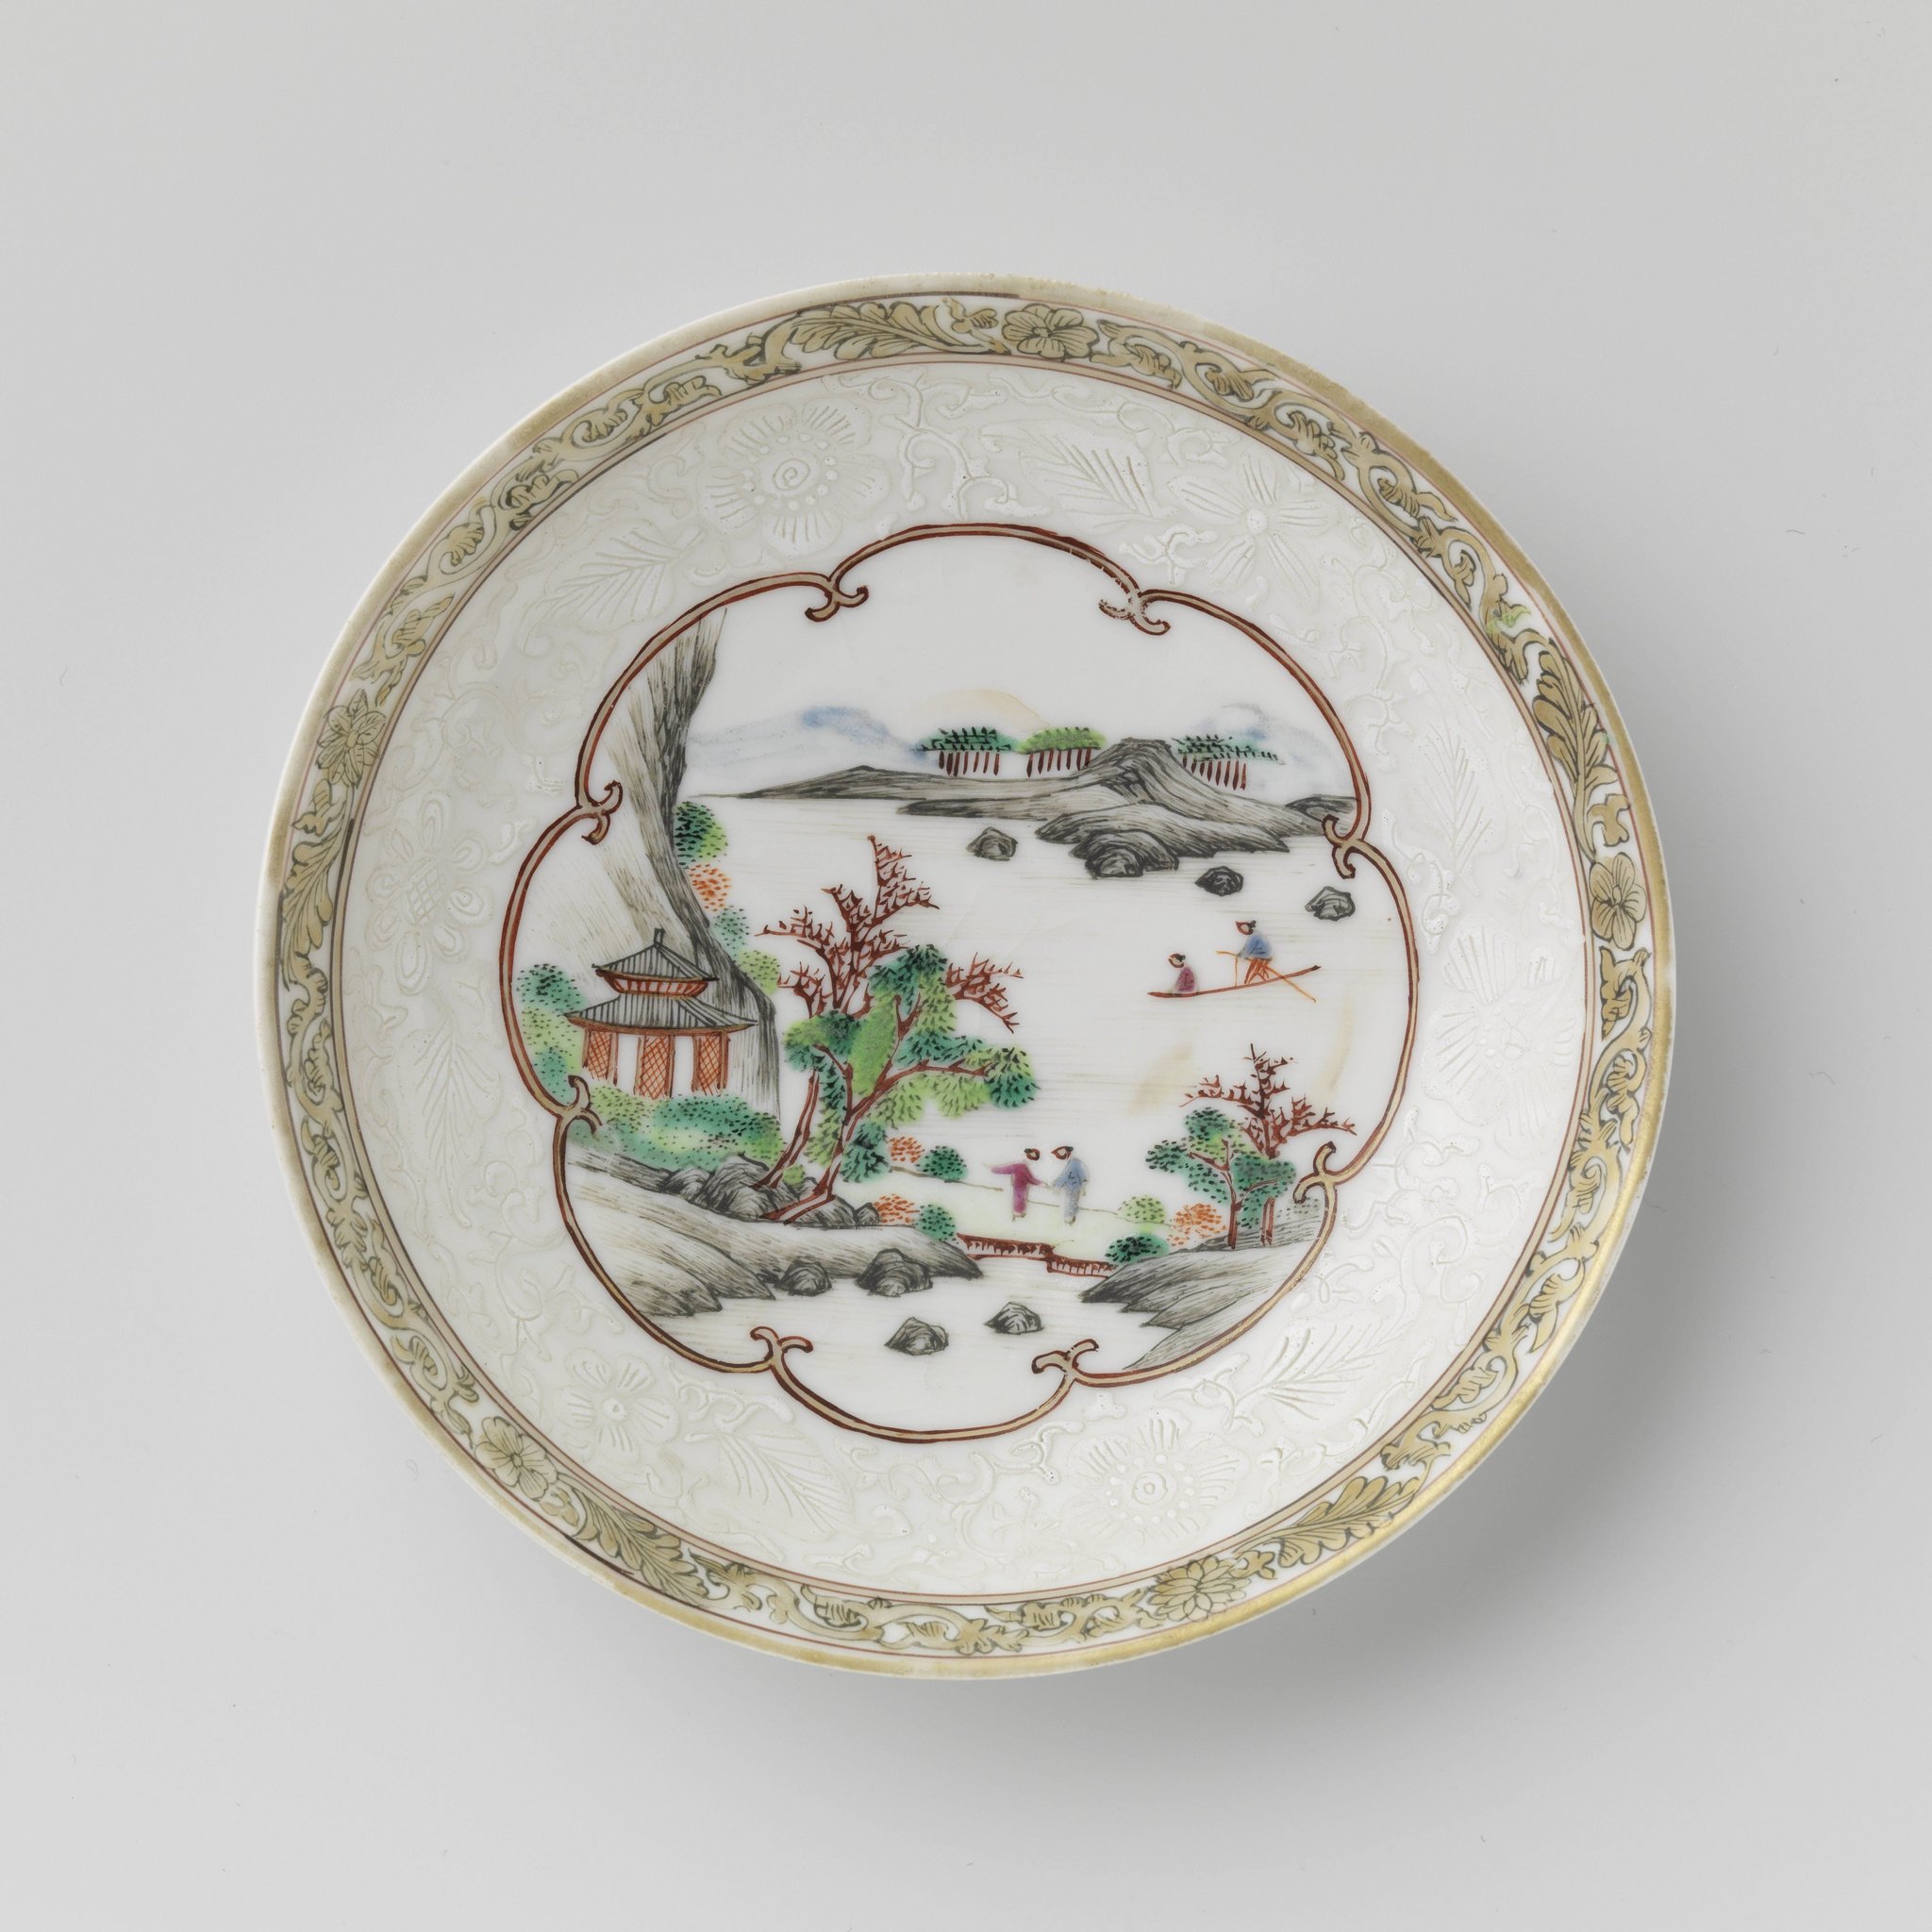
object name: platter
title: Saucer with a waterlandscape and flower scrolls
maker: Anonymous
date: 1725-1749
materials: glaze, gold, paint, porcelain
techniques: firing, gilding, turning, vitrification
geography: china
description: Schotel van porselein, beschilderd op het glazuur in blauw, rood, roze, groen, zwart en goud. Op het plat van de schotel een gelobd cartouche met hierin een rivierlandschap met paviljoen, personen, bomen en rotsen, om het cartouche bloemranken in bianco sopra bianco; de binnenrand met een band met bloemranken. Famille rose.